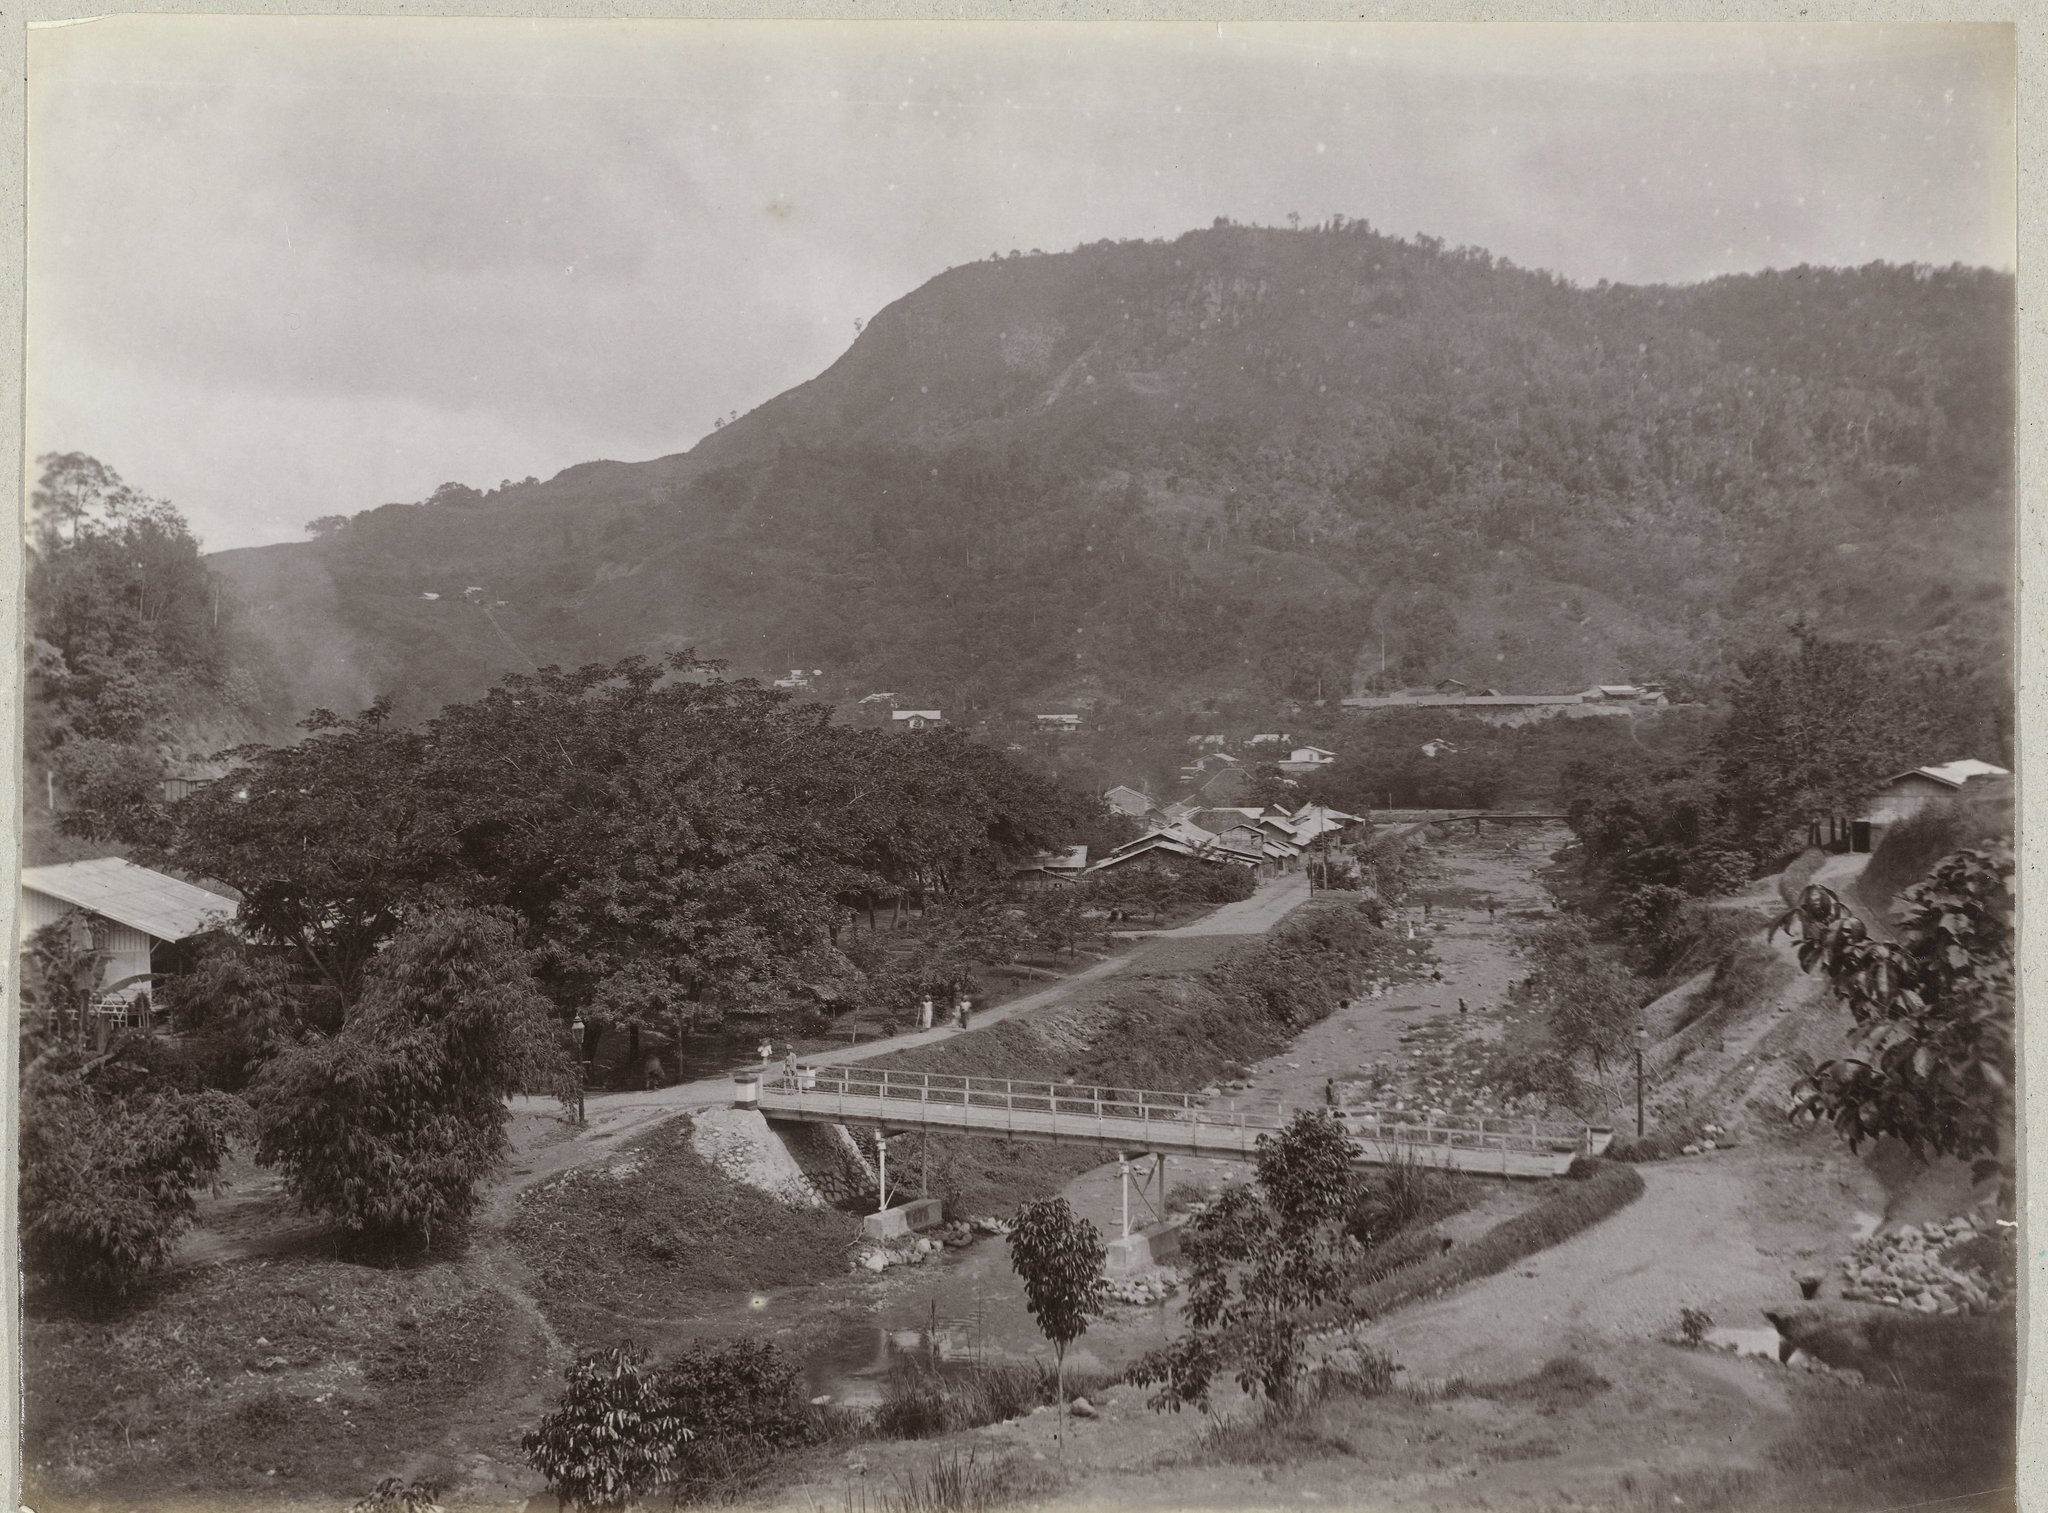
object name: photograph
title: Zicht op de rivier bij Sawahlunto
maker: christiaan benjamin nieuwenhuis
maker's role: publisher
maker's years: 1863-1922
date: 1891-1912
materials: paper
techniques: albumen print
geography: sawahlunto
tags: river, village, mountains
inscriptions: inscription: ‘Sawah Loento’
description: De rivier bij Sawahlunto met twee bruggen en op de achtergrond een berglandschap.